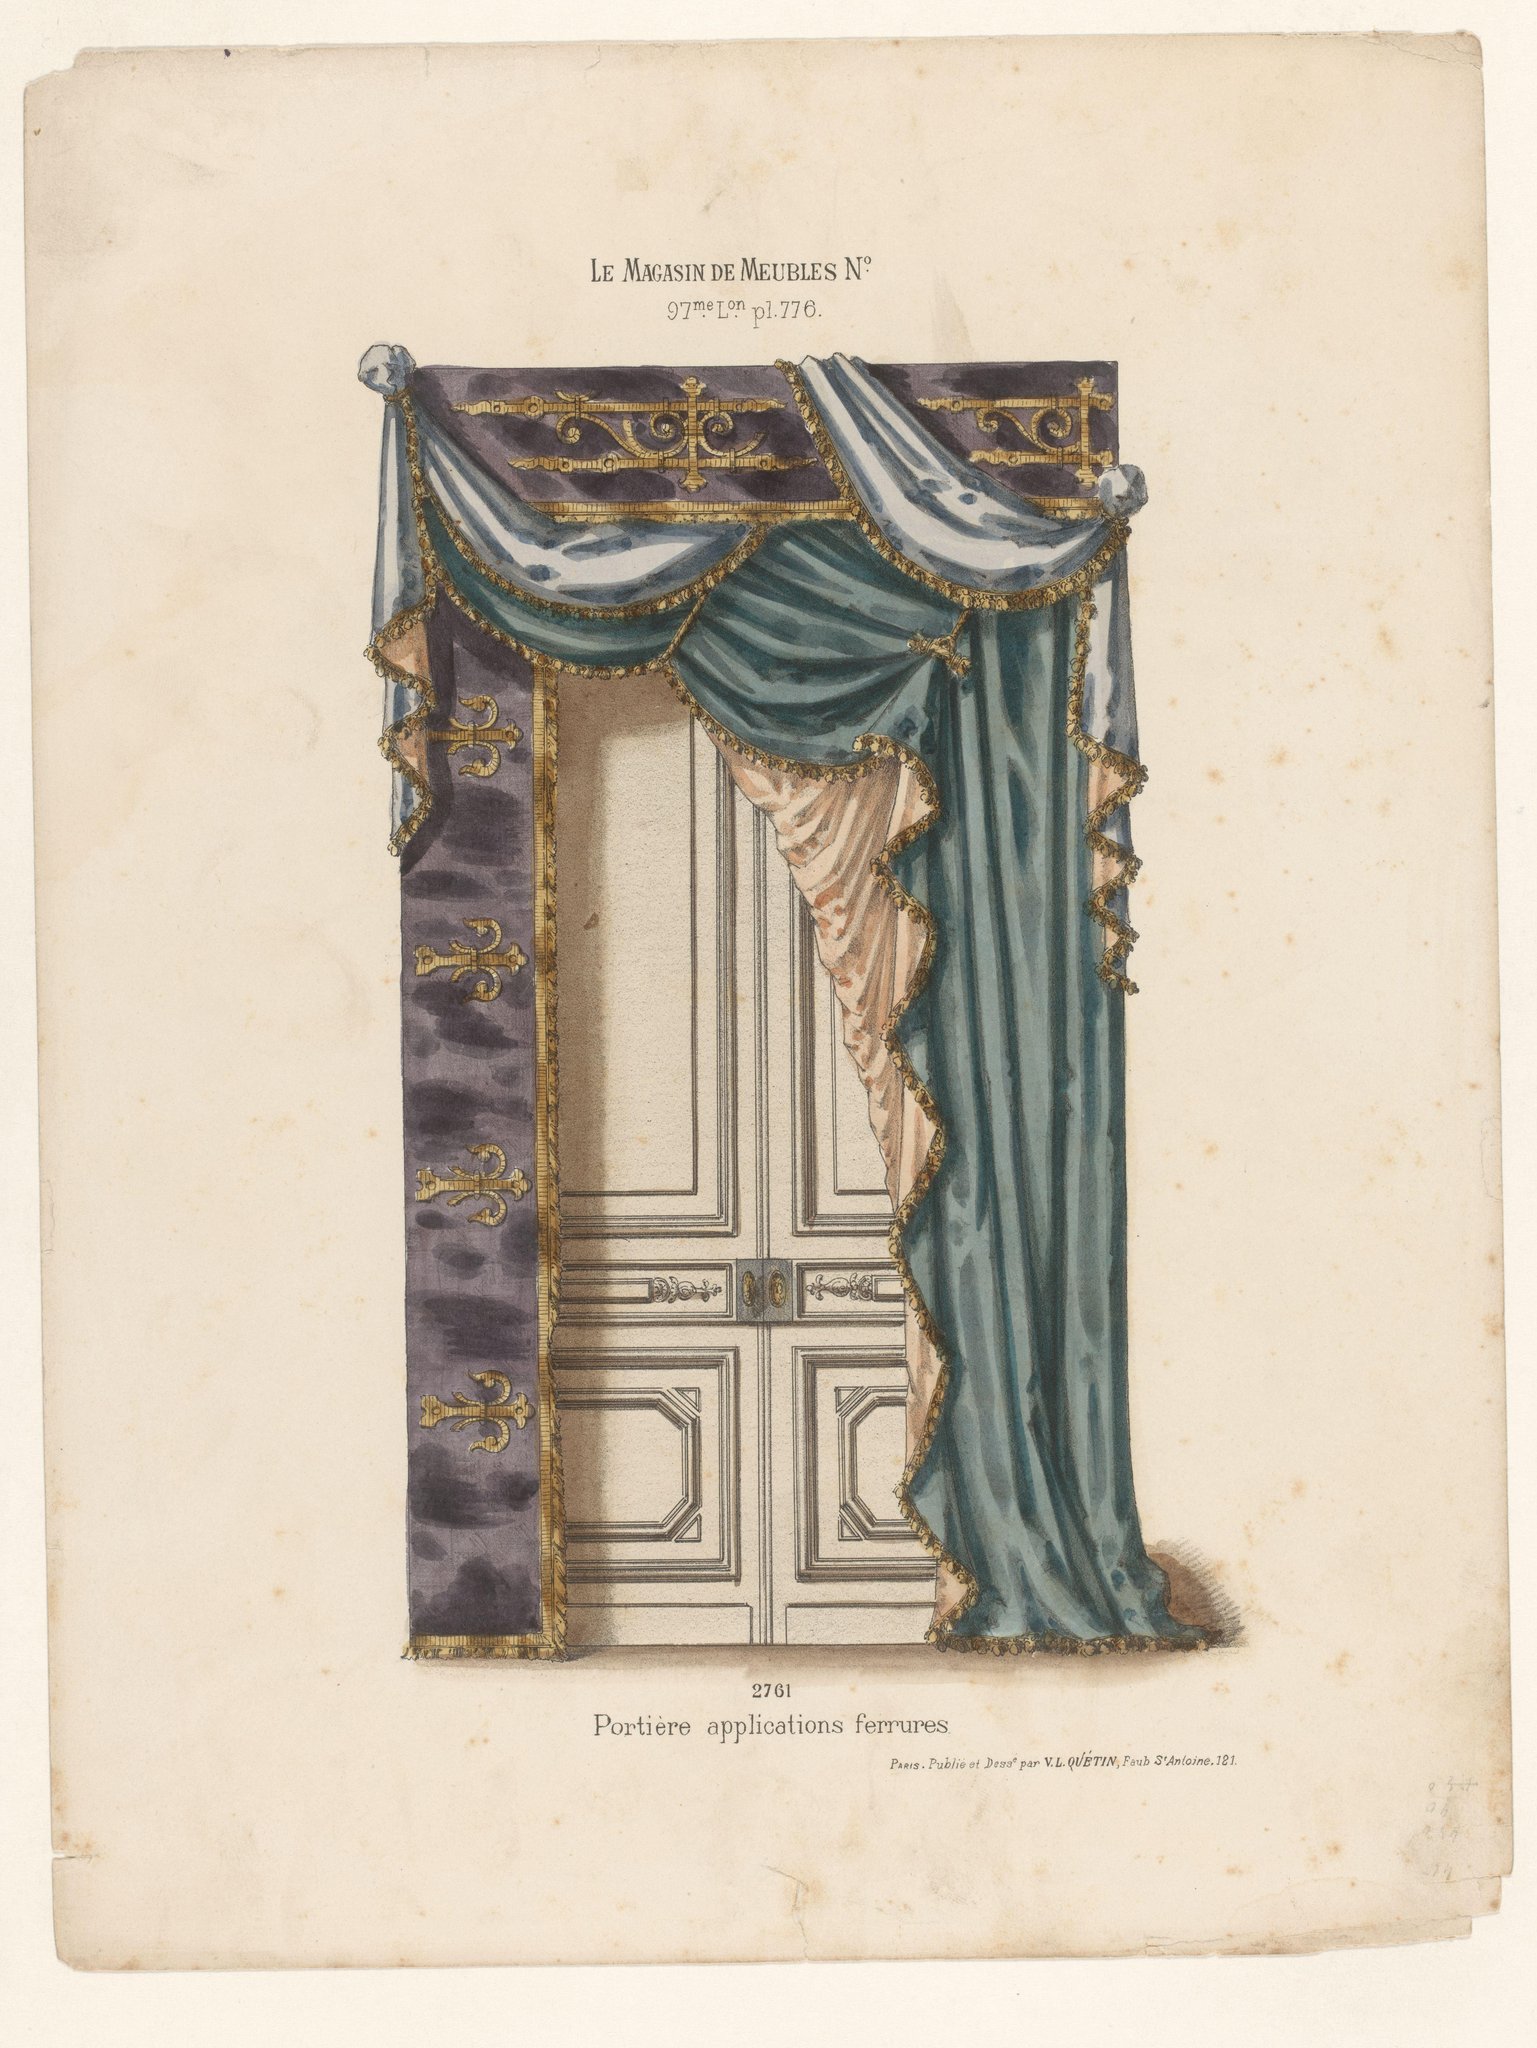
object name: print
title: Portière applications ferrures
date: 1878-1904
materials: paper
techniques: hand coloring, lithograph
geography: paris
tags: door, hangings and drapery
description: Een deur met gedrapeerde gordijnen. Prent uit 97e Livraison.